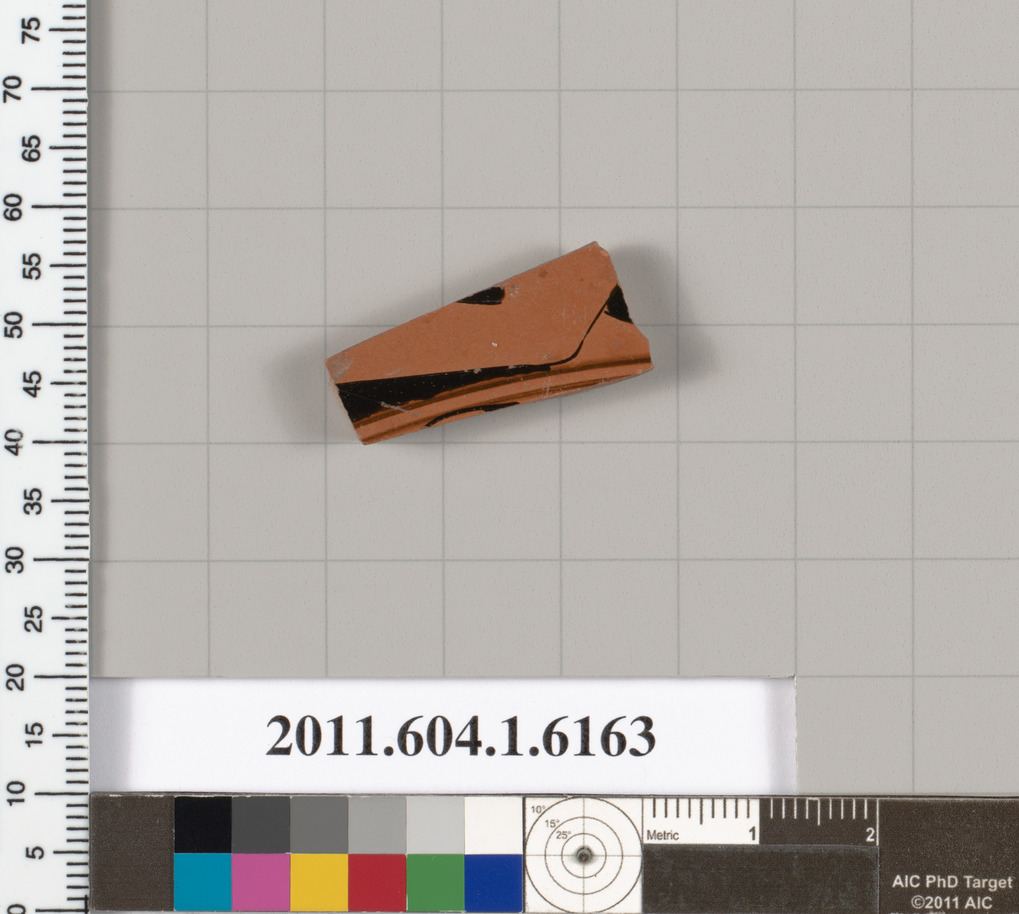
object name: kylix fragment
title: Terracotta fragment of a kylix (drinking cup)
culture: greek, attic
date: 520-500 BCE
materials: terracotta